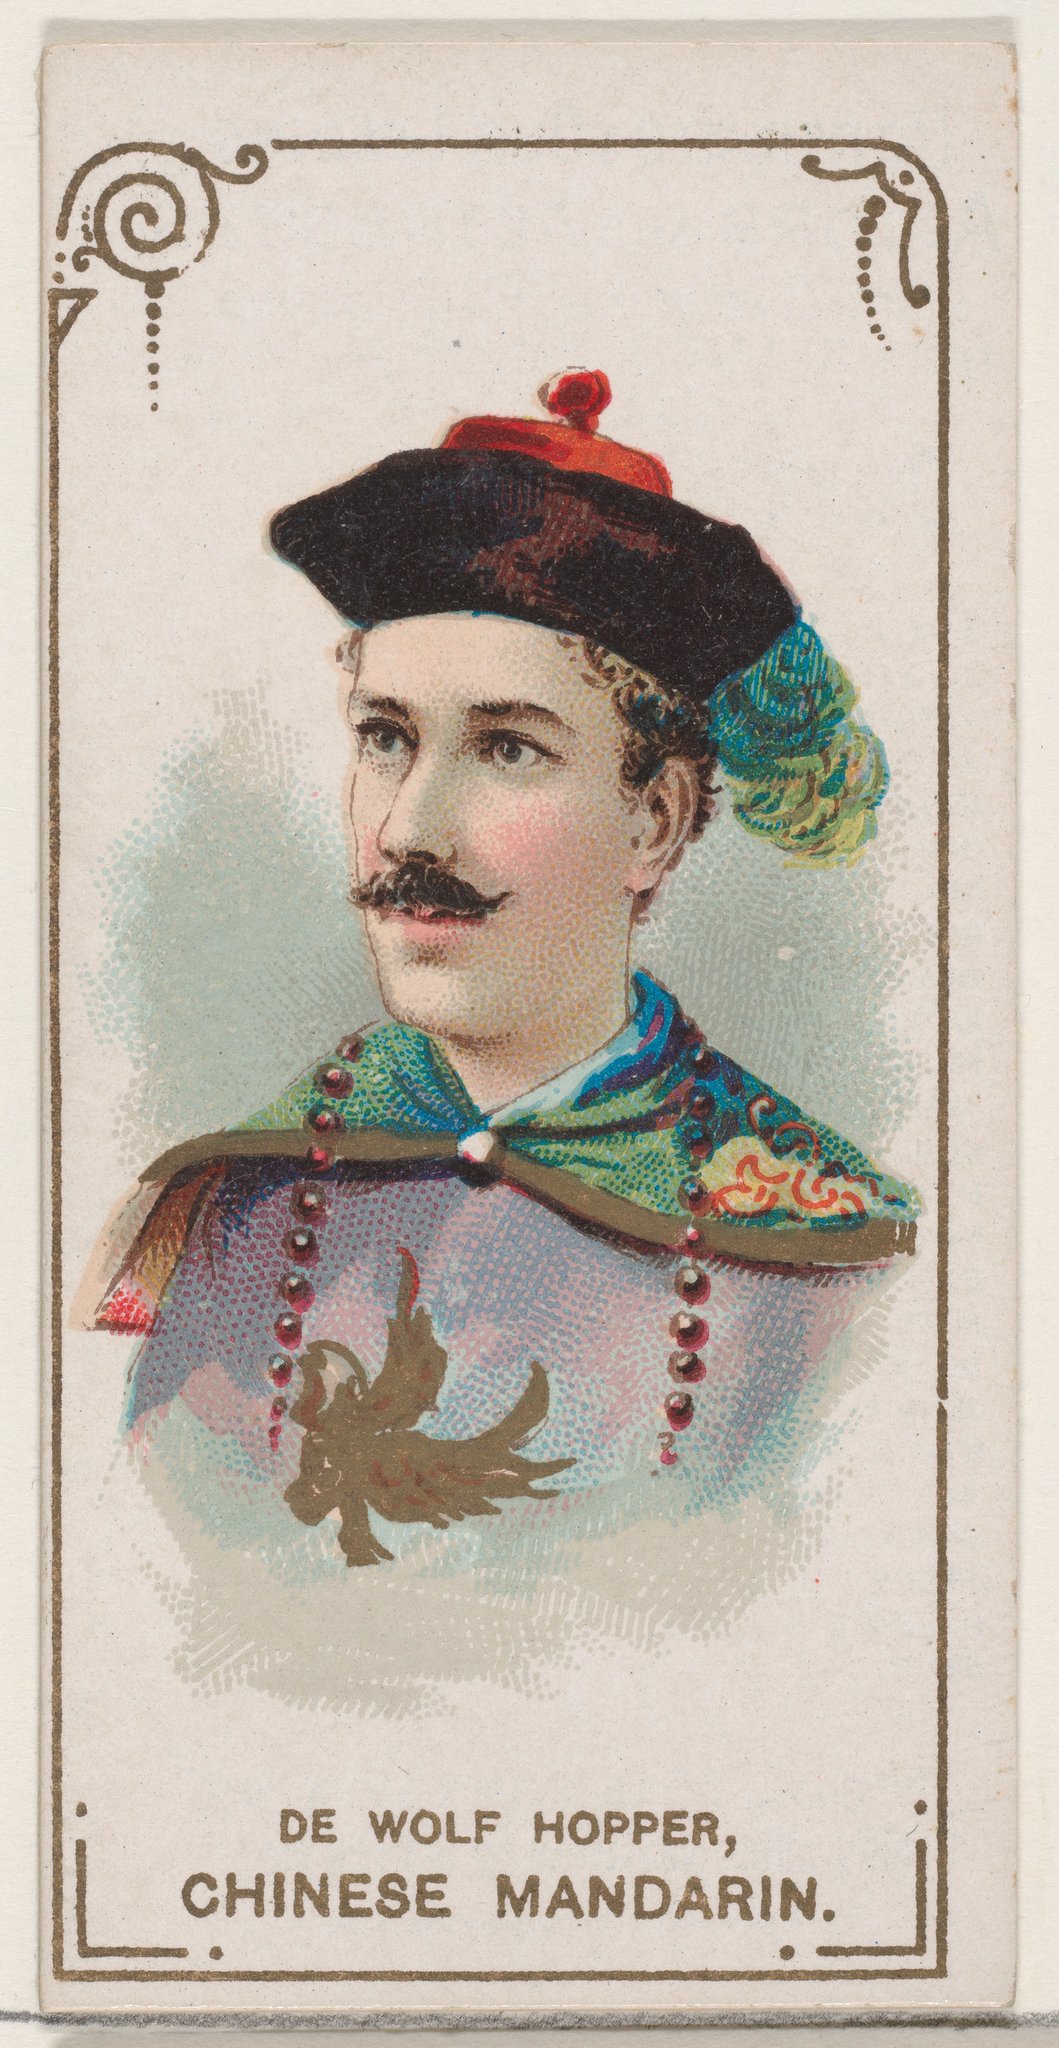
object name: print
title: De Wolf Hopper Dressed as Chinese Mandarin, from the set Actors and Actresses, Second Series (N71) for Duke brand cigarettes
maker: w. duke, sons & co.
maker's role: publisher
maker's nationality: american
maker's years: 1870-1920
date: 1888-1890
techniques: color lithograph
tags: men,actors